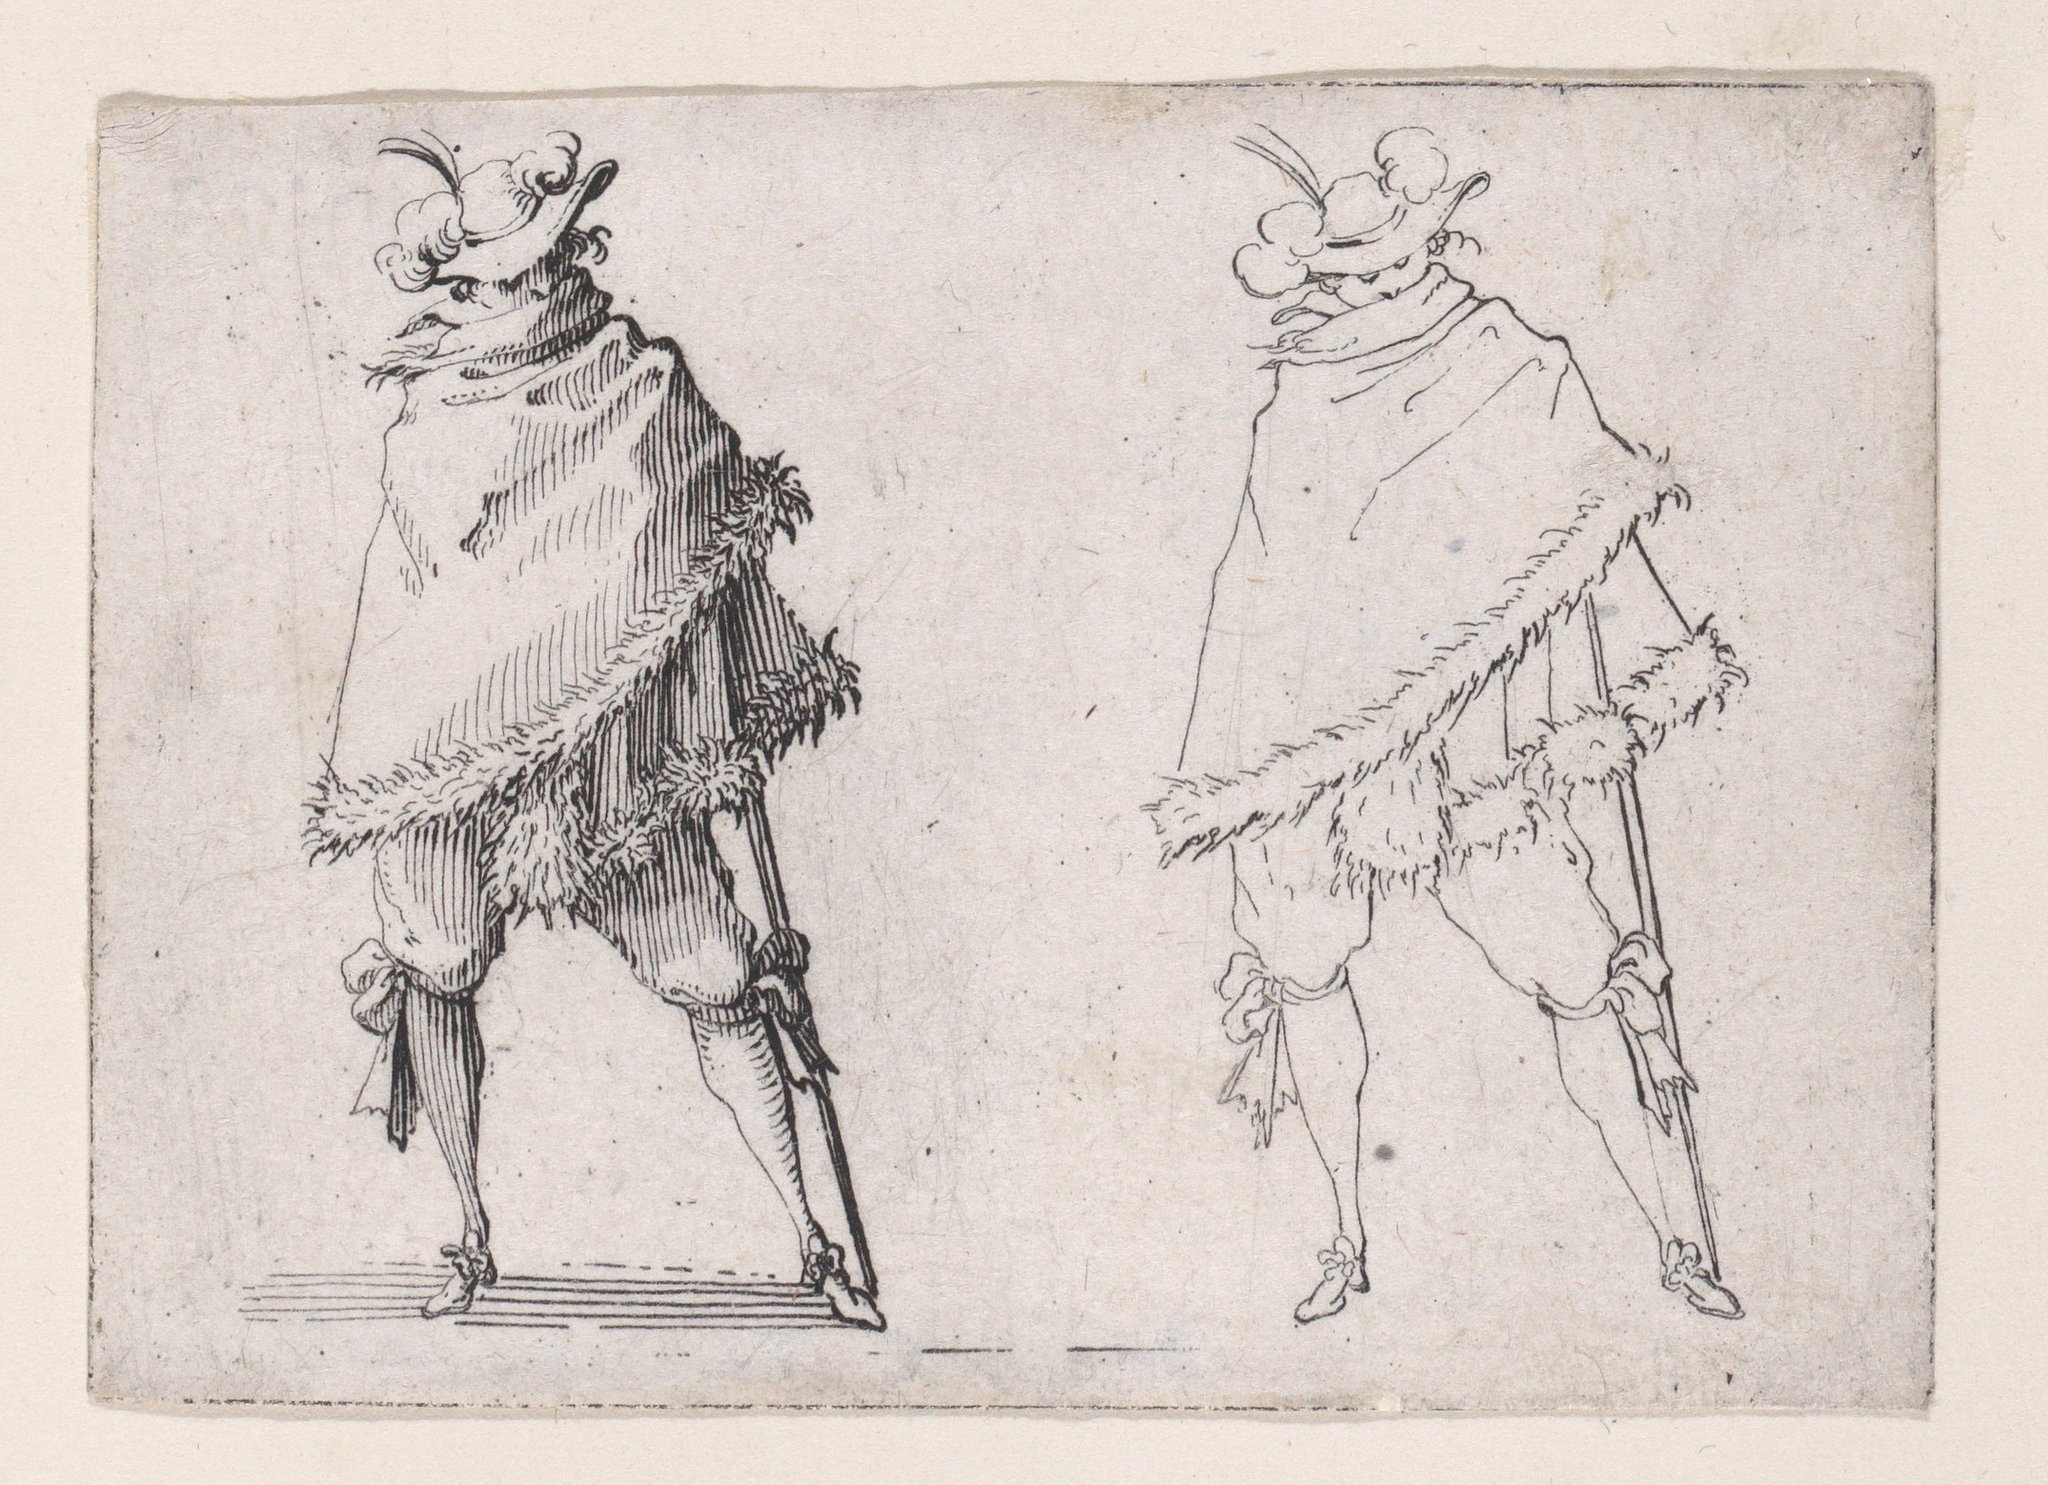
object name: print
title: L'Homme Enroulé dans son Manteau (The Man Wrapped in his Mantle), from "Les Caprices" Series A, The Florence Set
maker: jacques callot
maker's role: artist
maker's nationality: french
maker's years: 1592-1635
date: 1617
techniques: etching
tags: men